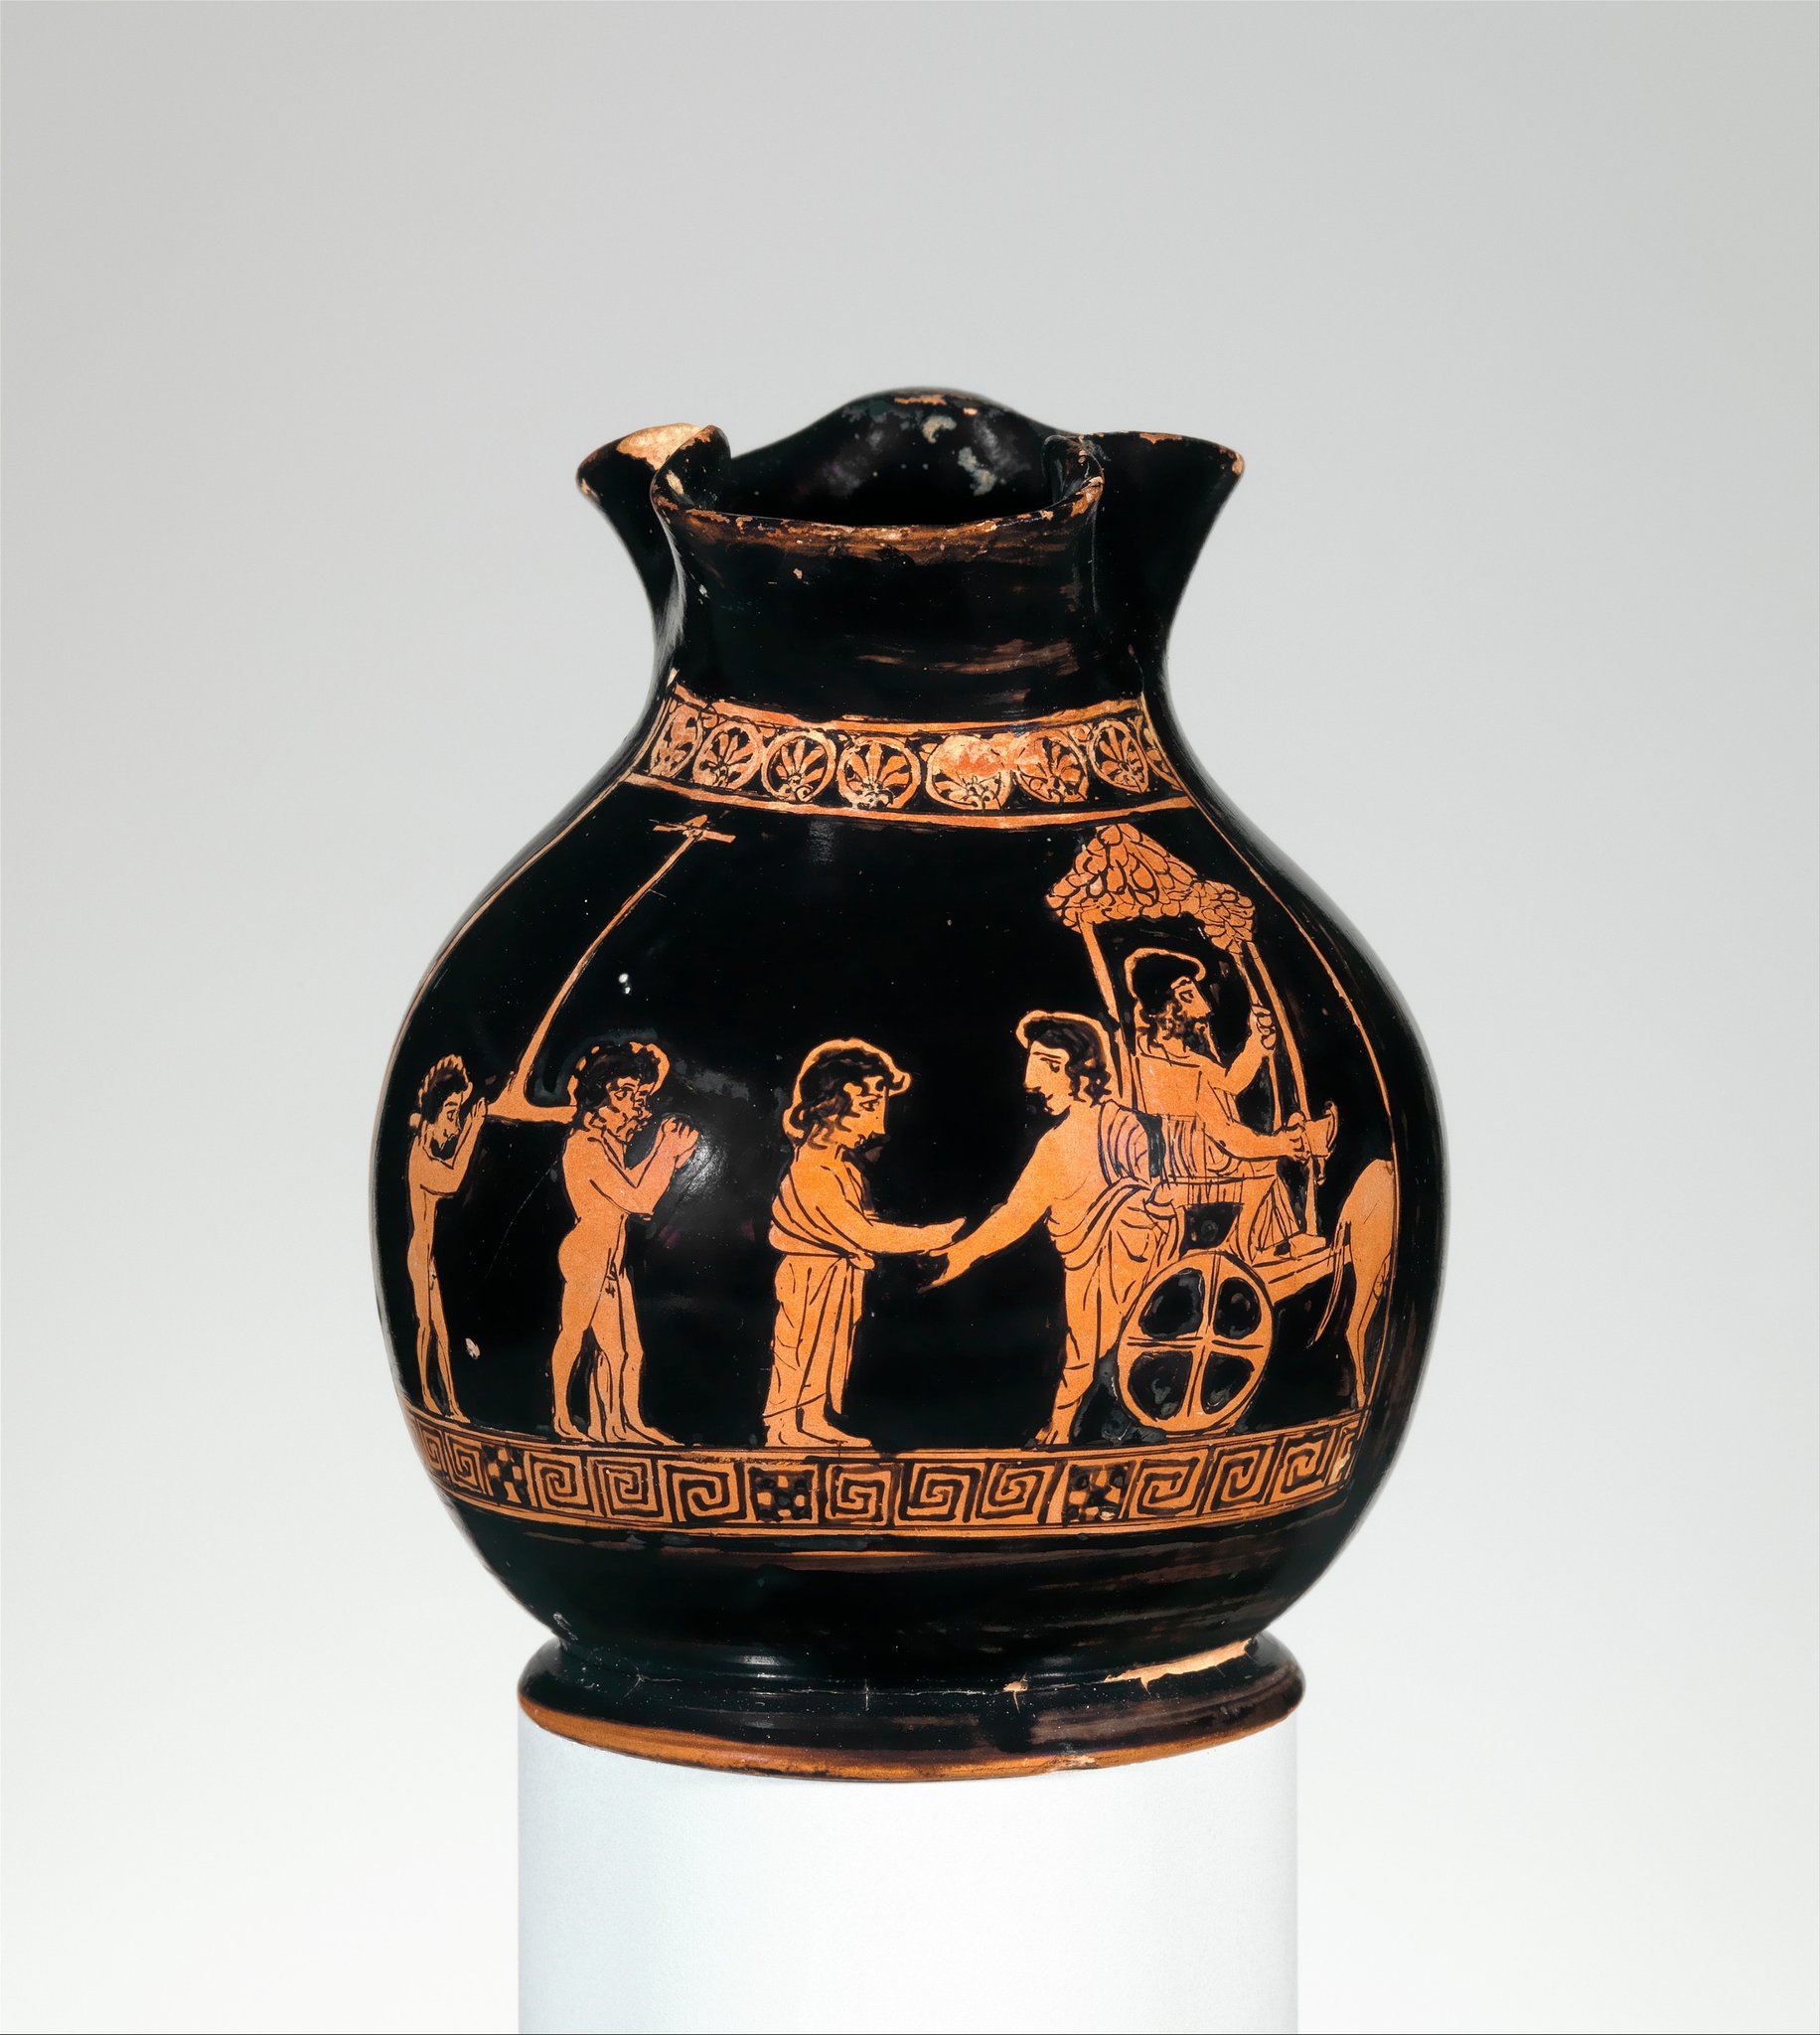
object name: oinochoe, chou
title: Terracotta oinochoe: chous (jug)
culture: greek, attic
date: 450-401 BCE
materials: terracotta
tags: animals,male nudes,women